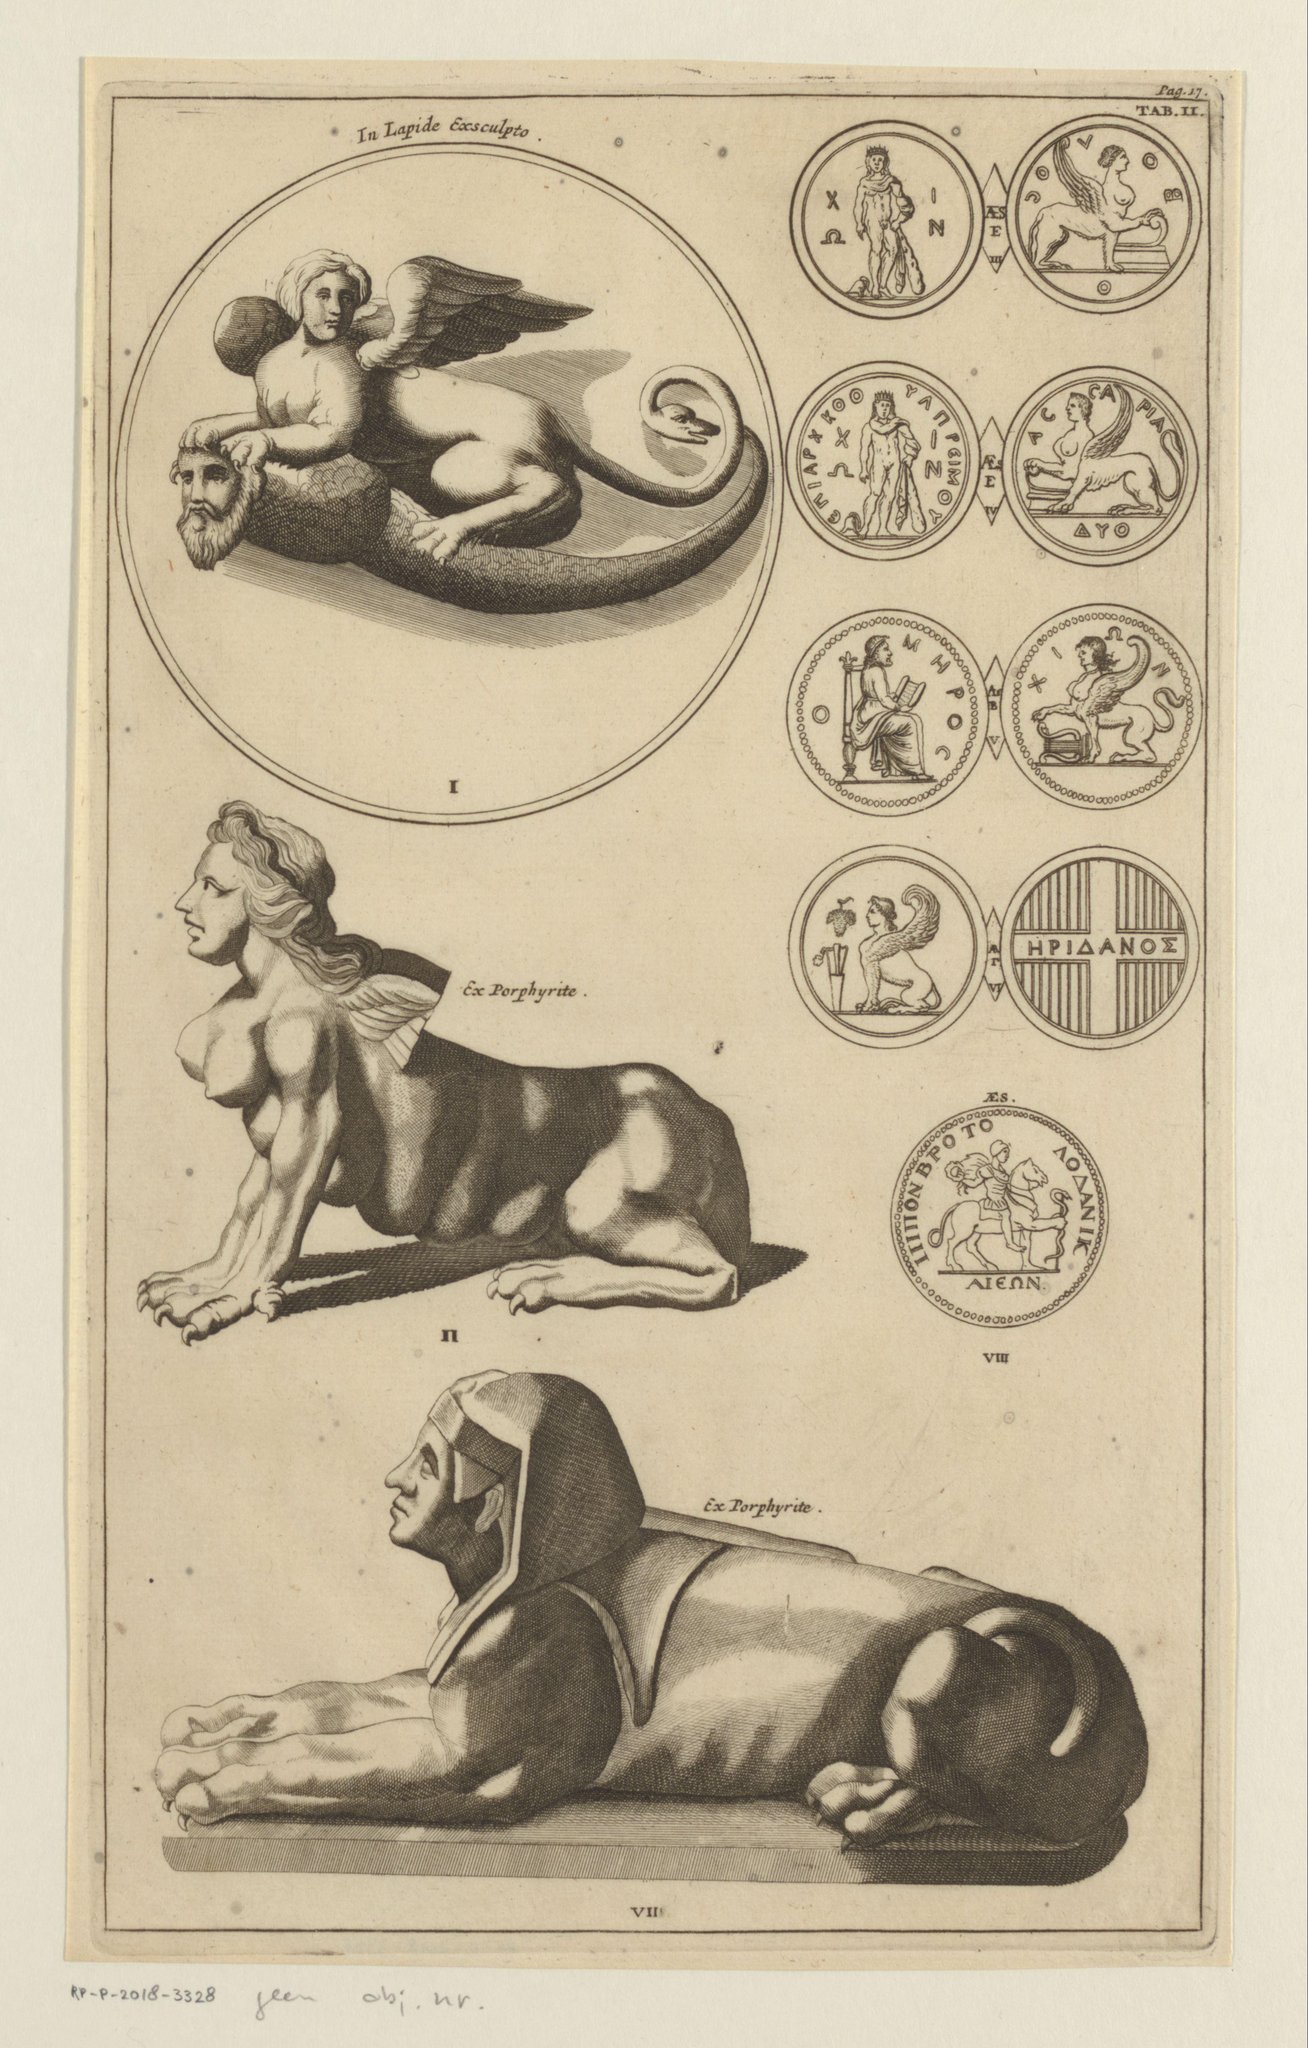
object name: book illustration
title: Verschillende munten en drie beelden van sfinxen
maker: Anonymous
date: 1700-1799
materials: paper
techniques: engraving, etching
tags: sphinx (lion/woman); 'sfinge' (ripa) - aa - female human figure, coin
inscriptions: collector's mark: Lugt 2228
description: Prent uit een onbekend boek met objecten, kunstwerken en figuren uit de Romeinse geschiedenis en religie. Dit betreft een illustratie bij p. 17.